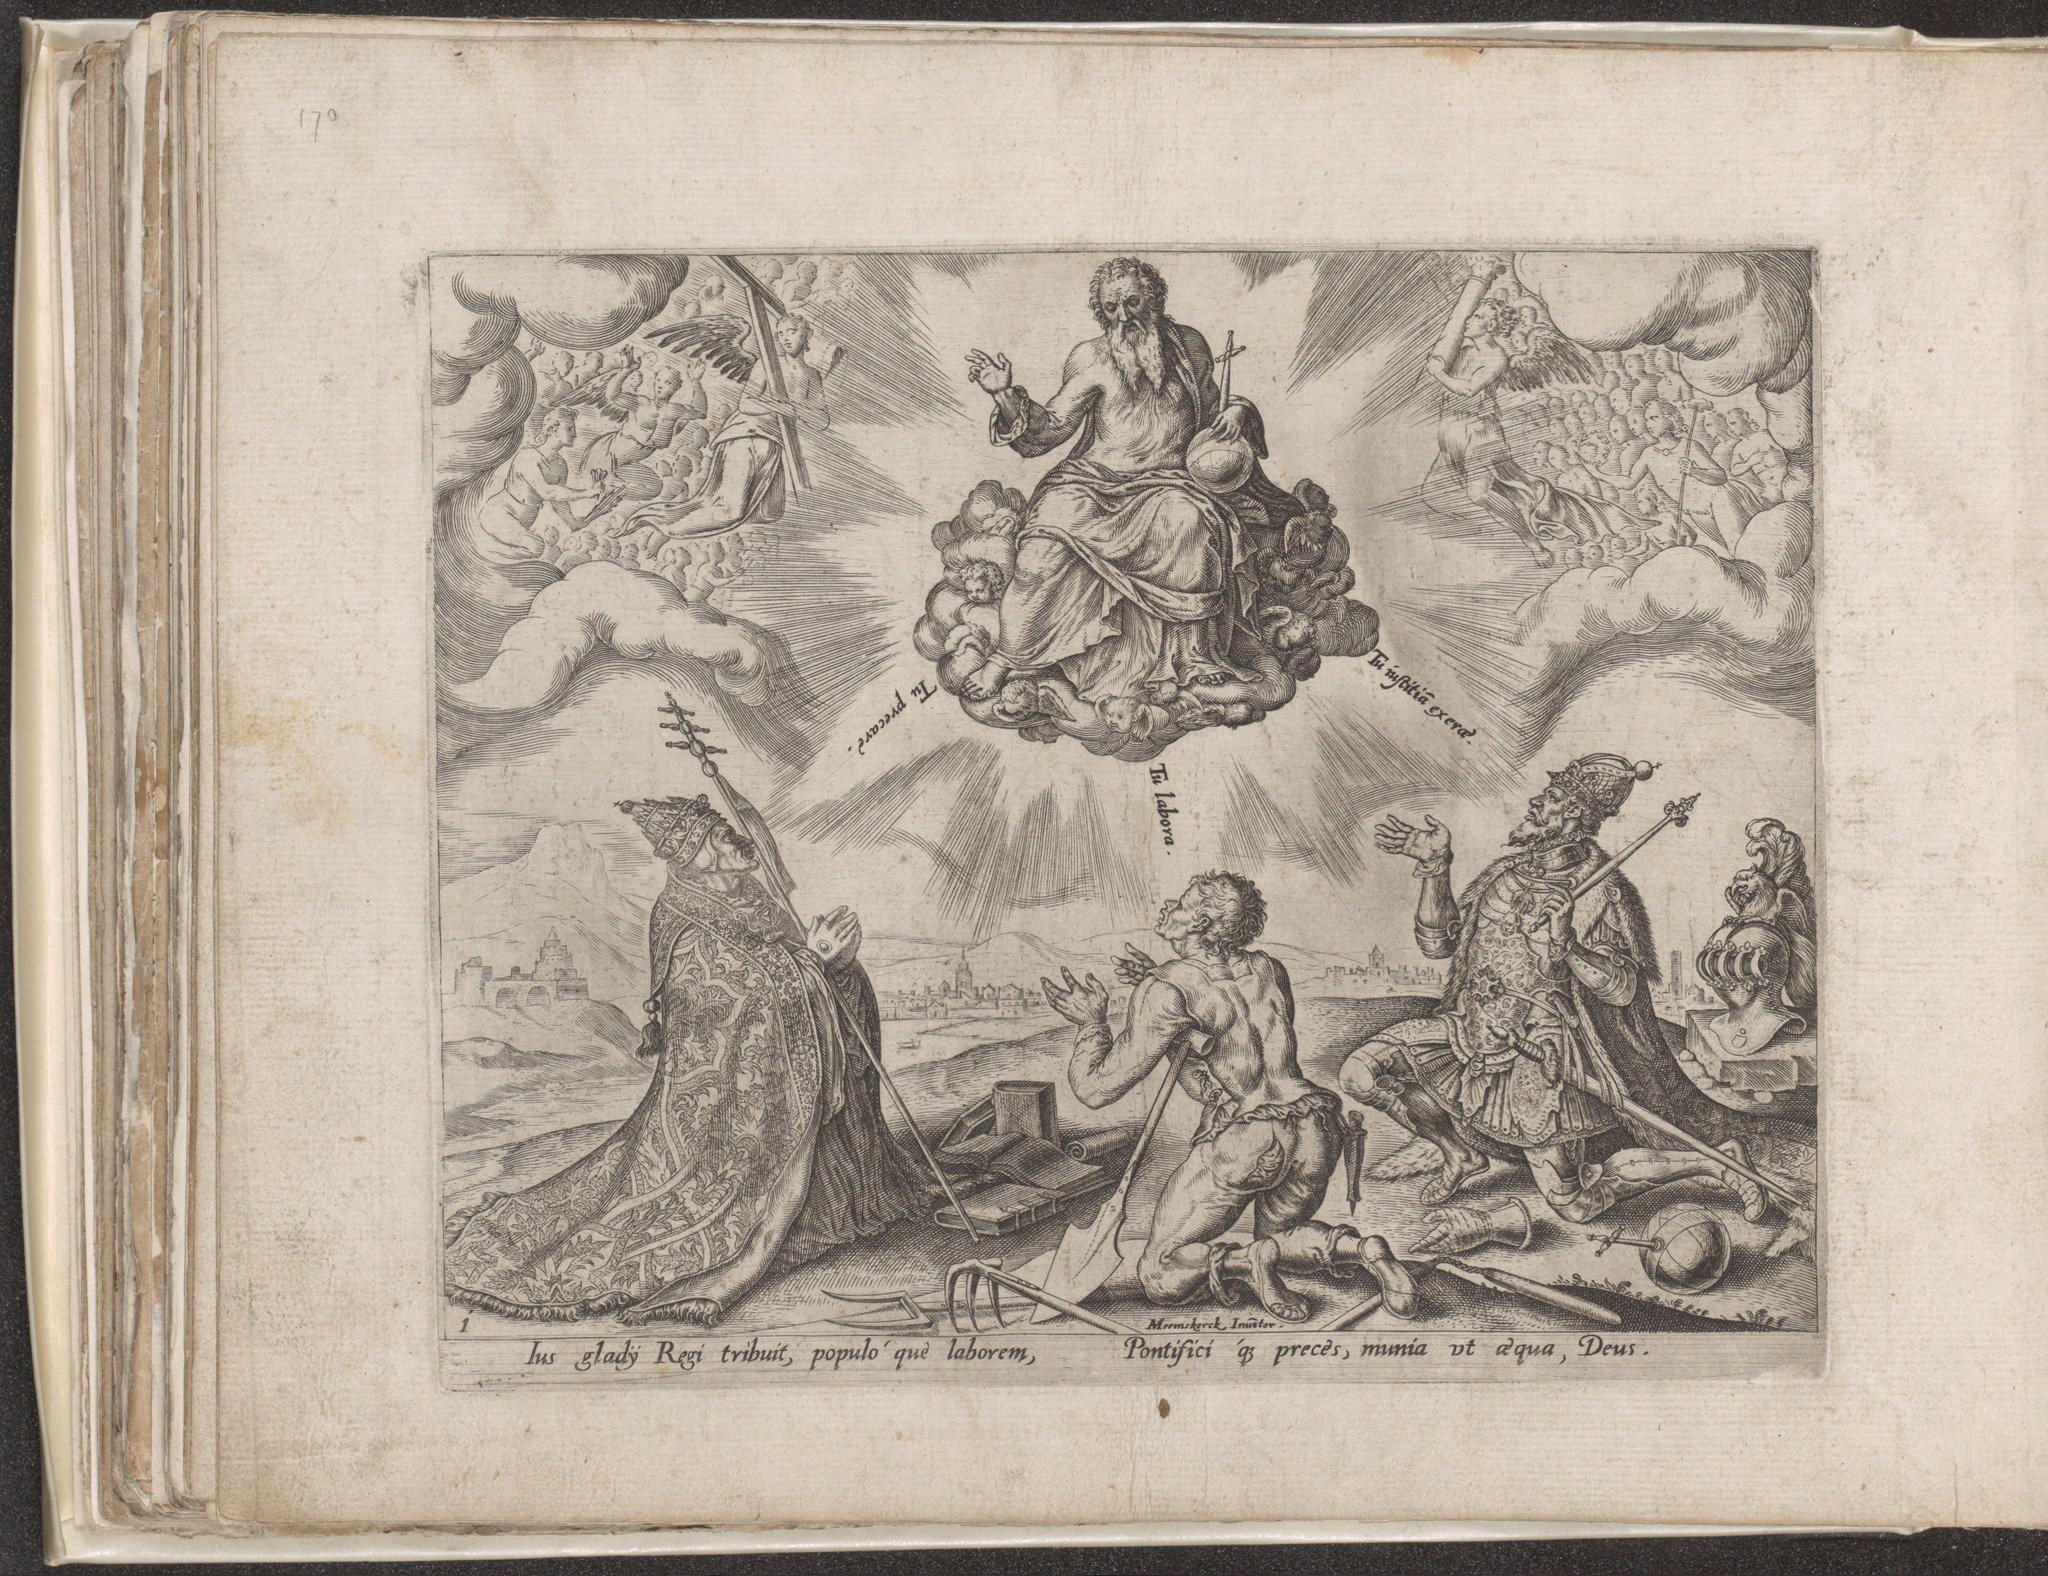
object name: print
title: Taken van de drie standen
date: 1563-1570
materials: paper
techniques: engraving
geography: haarlem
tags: god the father, the three estates: nobility, clergy, commoners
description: God, zittend op een wolk met cherubijnen, geeft de knielende paus, keizer en landbouwer elk een opdracht. De paus, als hoofd van de geestelijke stand, behoort te bidden voor het zielenheil van ieder individu (Tu precare). De keizer, samen met de rest van de heersende klasse, dient de rechtstaat te handhaven (Tu iustitiam exercere). De landbouwer vertegenwoordigt het grootste deel van de bevolking, de derde stand. Hij dient te werken om zo de rest van de bevolking te voeden en welvaart te creëren (Tu labora). Onder de voorstelling een verklarende tekst in het Latijn. Deze prent maakt deel uit van een album.